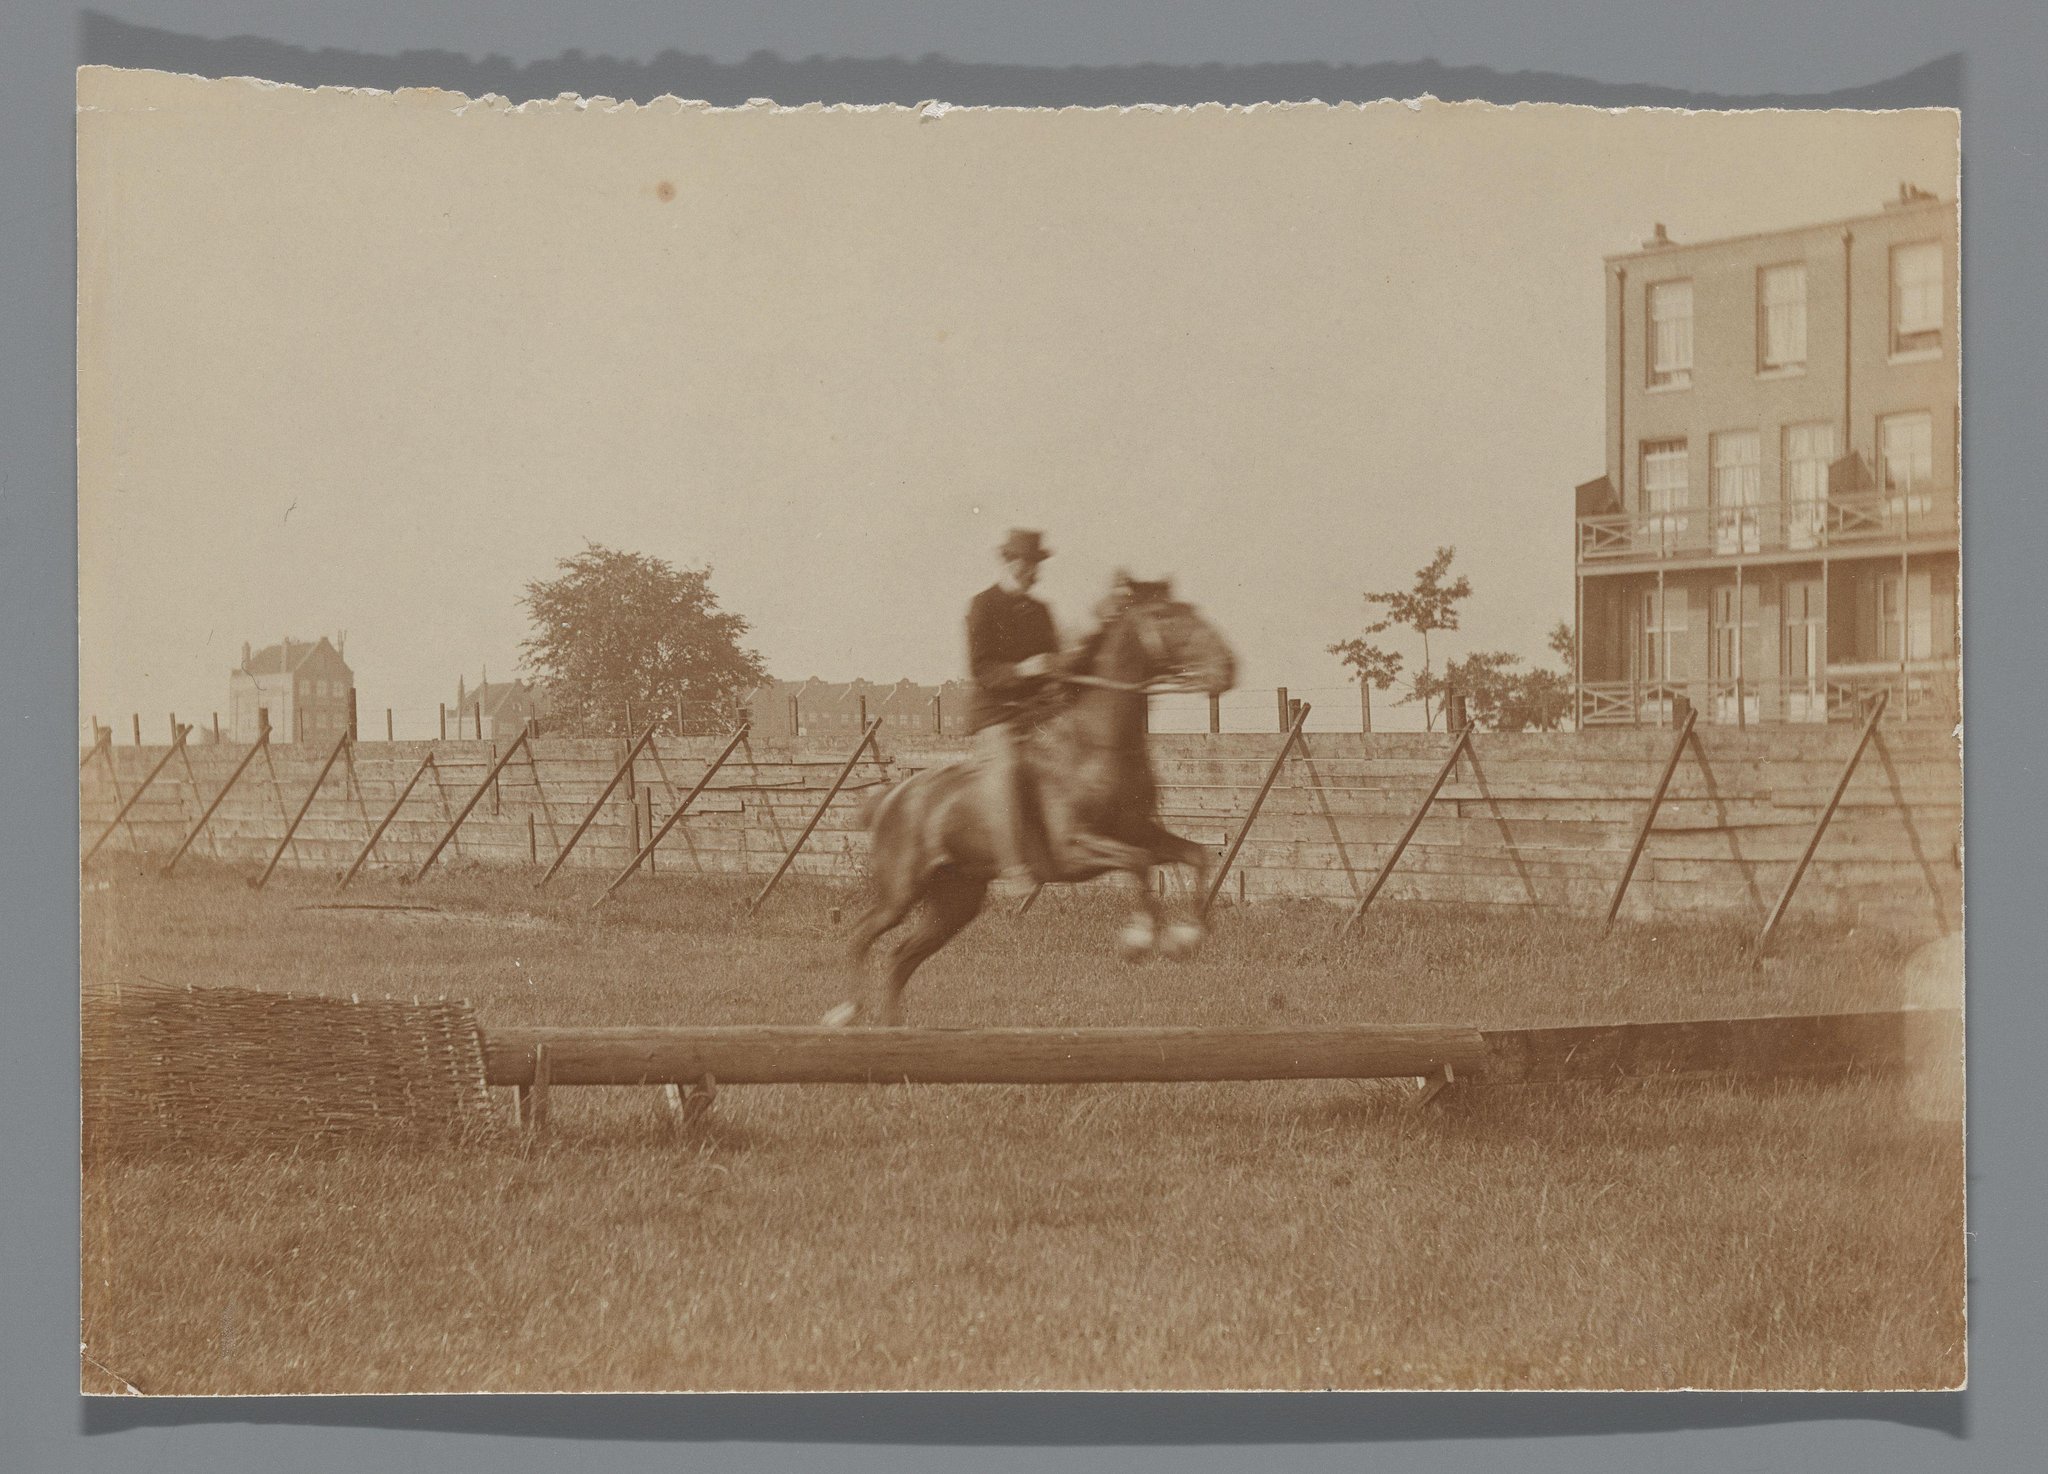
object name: photograph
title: A Man Riding the Photographer’s Horse Bobbie Taking an Obstacle on the Terrain behind the Rijksmuseum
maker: hendrik herman van den berg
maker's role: amateurfotograaf, jurist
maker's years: 1875-1944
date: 1890-1900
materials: photographic support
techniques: collodion silver print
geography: amsterdam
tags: amsterdam